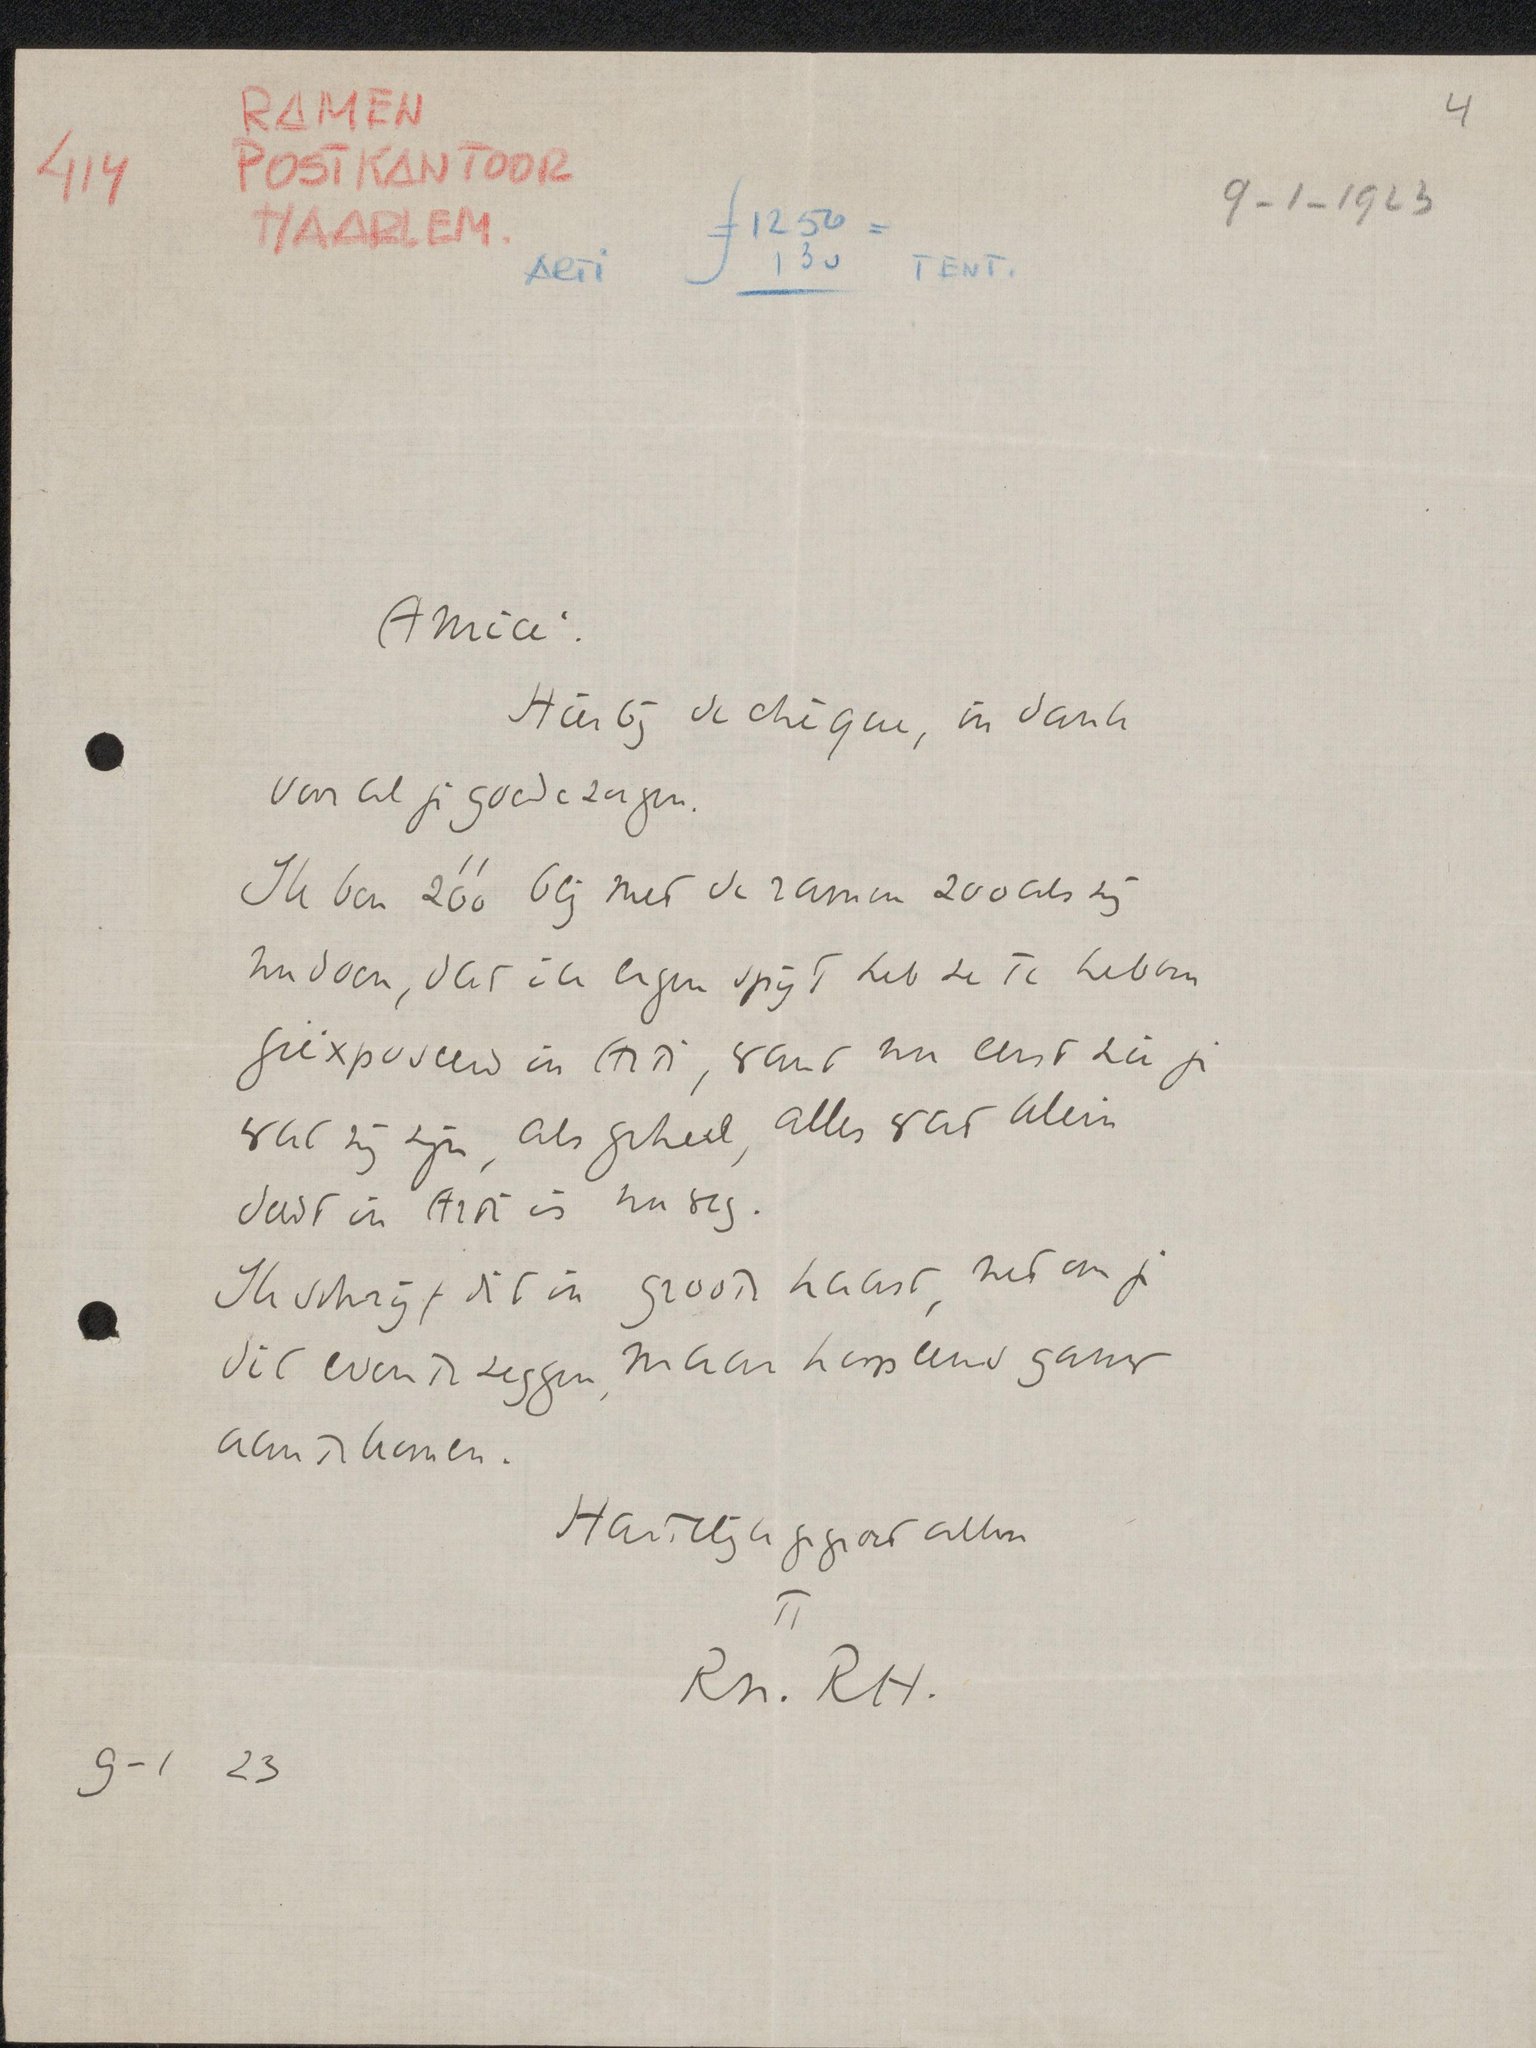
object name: letter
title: Brief aan Willem Bogtman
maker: richard nicolaüs roland holst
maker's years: 1868-1938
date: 1923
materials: ink, paper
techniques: pen, writing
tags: haarlem, willem bogtman, applied arts, arts and crafts; industrial design, exhibition ~ art, money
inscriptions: watermark